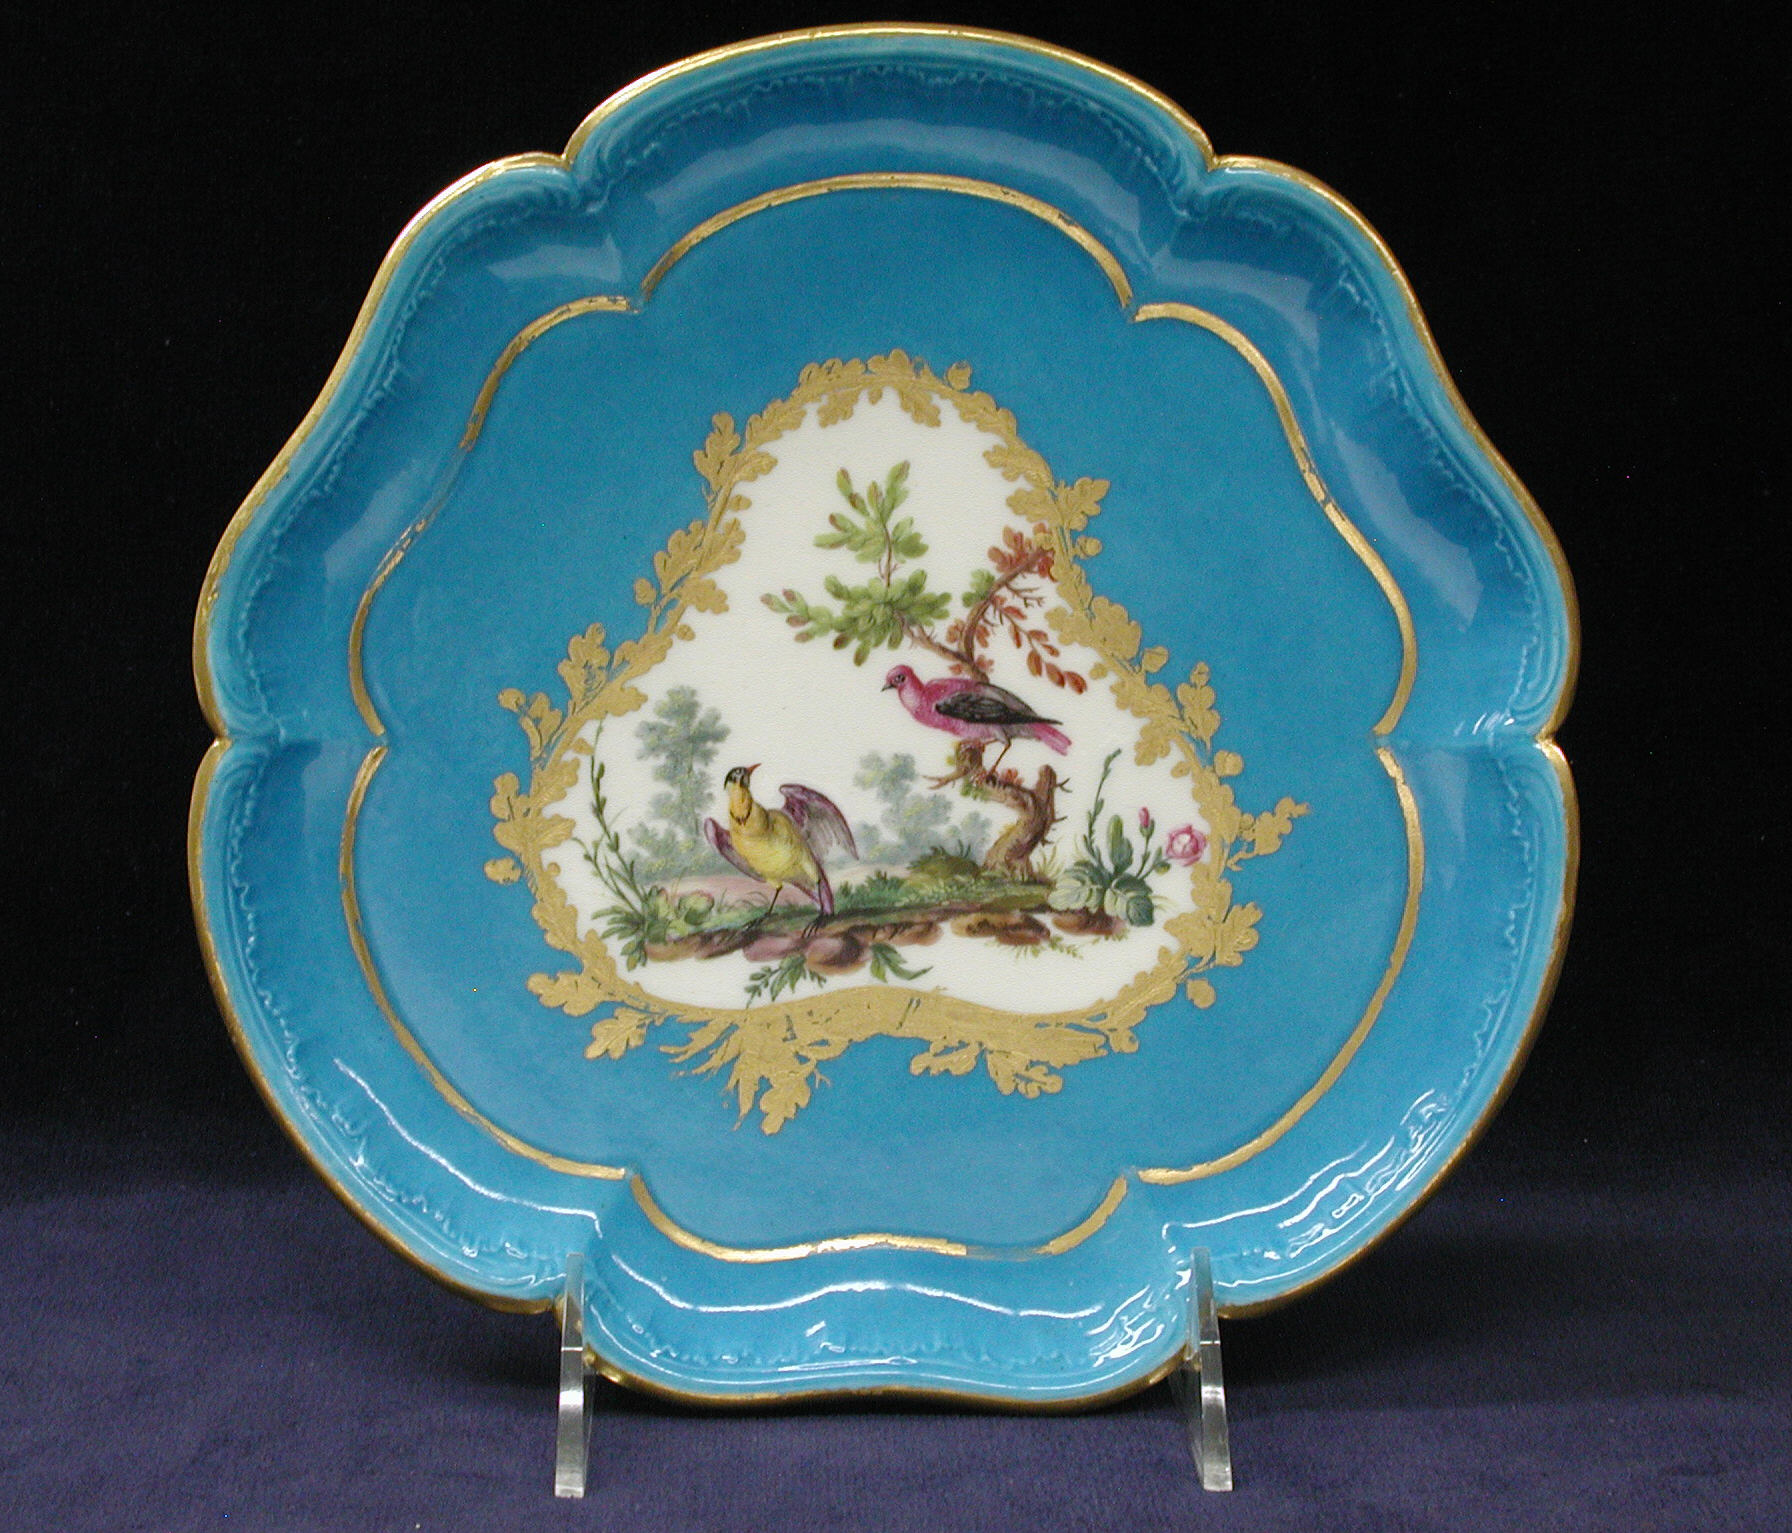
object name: stand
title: Stand for ice-cream cup (plateau Bouret) (one of four) (part of a service)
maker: sèvres manufactory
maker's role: manufactory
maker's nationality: french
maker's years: 1740-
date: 1771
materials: soft paste porcelain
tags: birds,trees